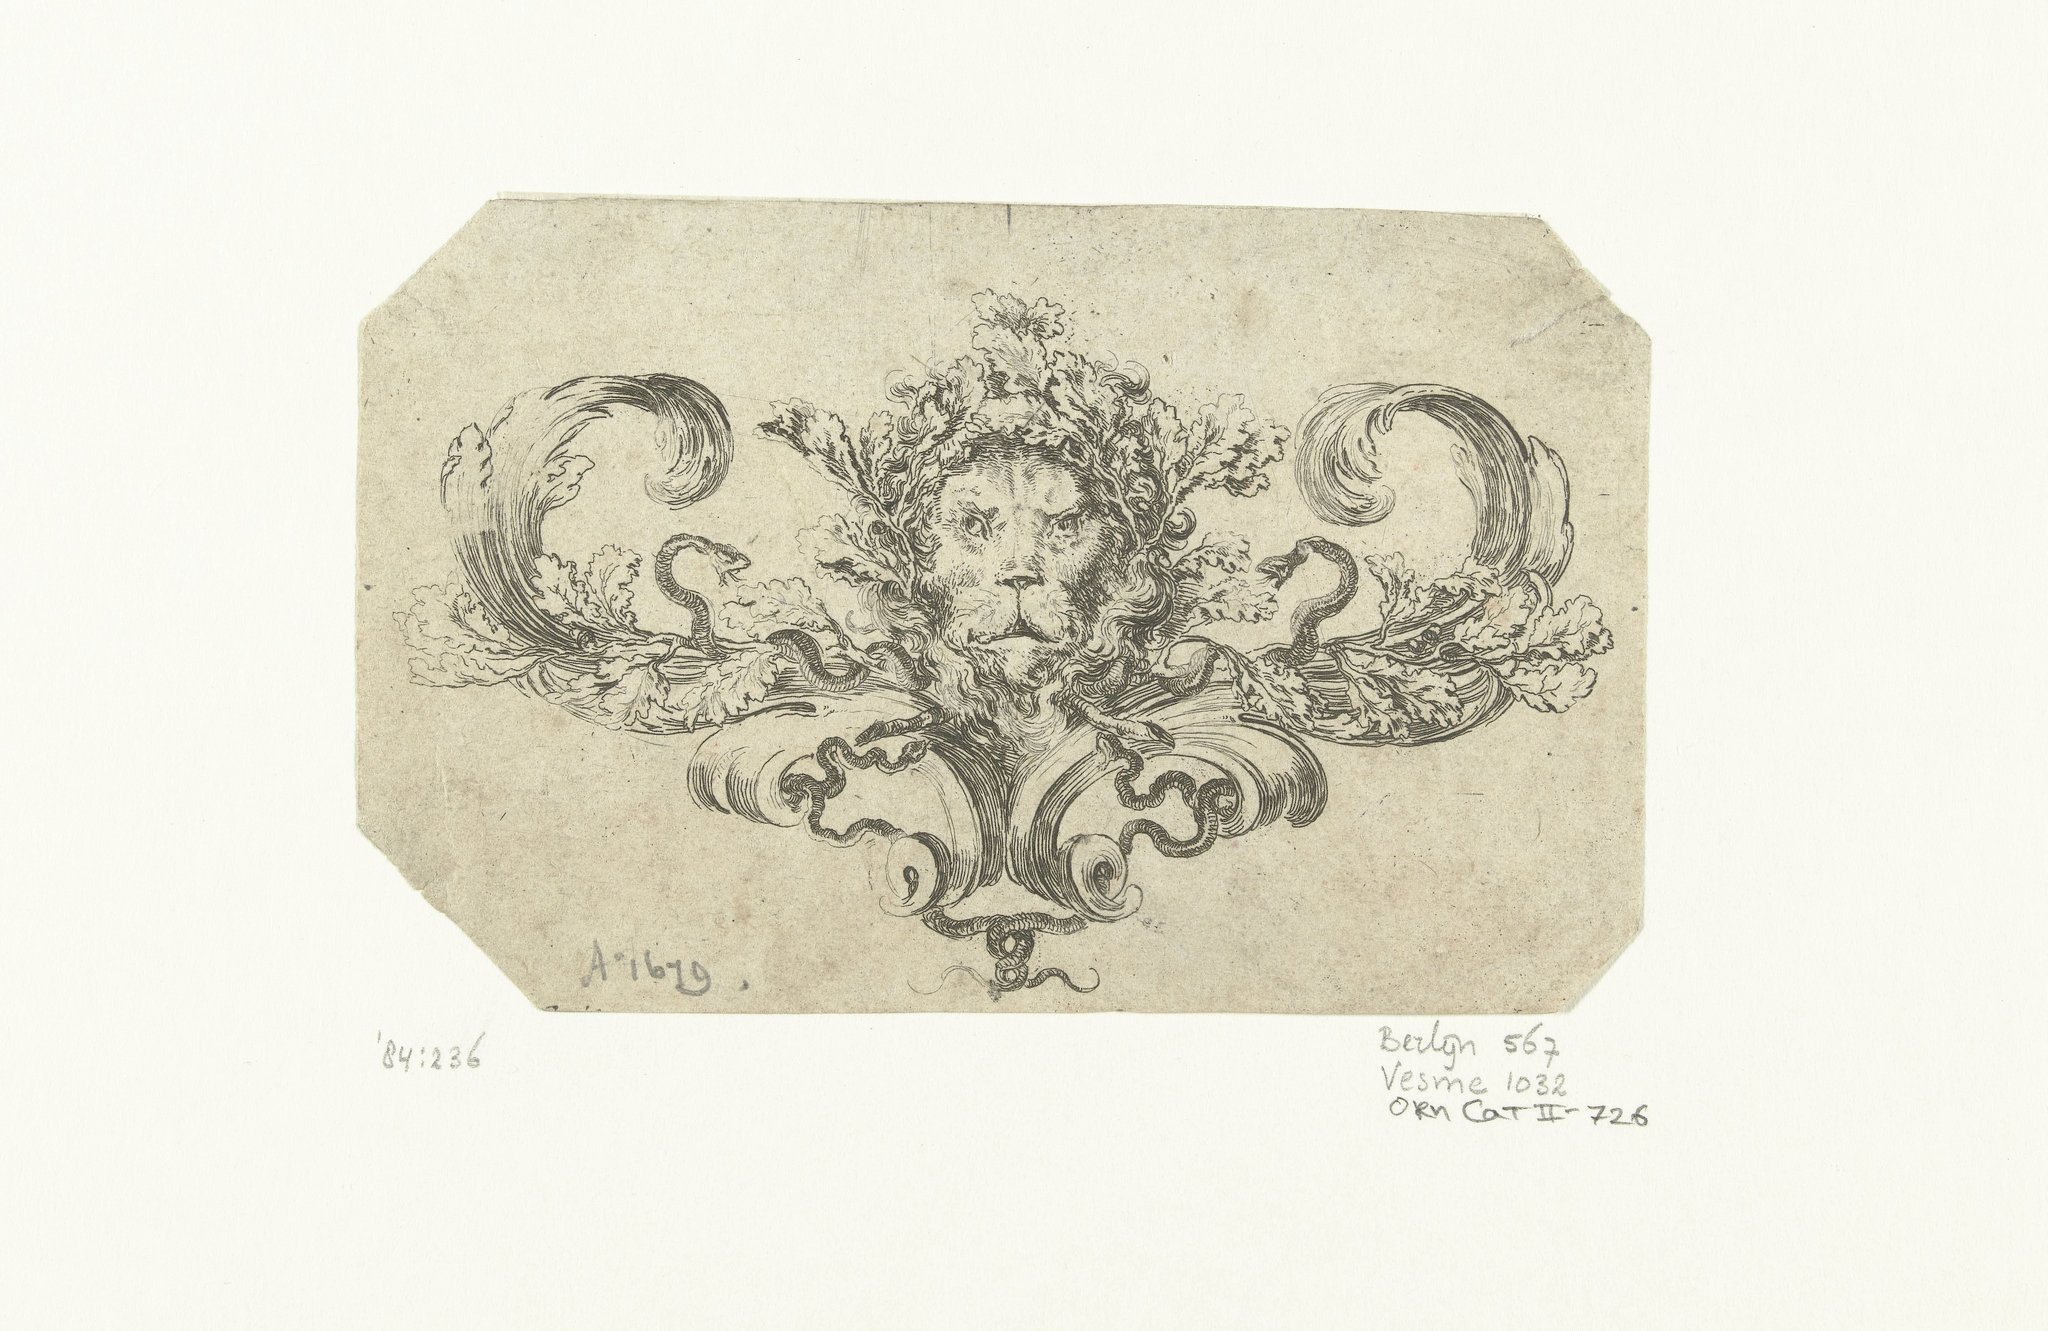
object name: ornament print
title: Raccolta Di Varii Cappricii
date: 1646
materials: paper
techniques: etching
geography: italy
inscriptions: annotation: ‘A° 1679’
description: De hoeken van het blad zijn schuin afgesneden. Blad 6 uit serie van 18 bladen.